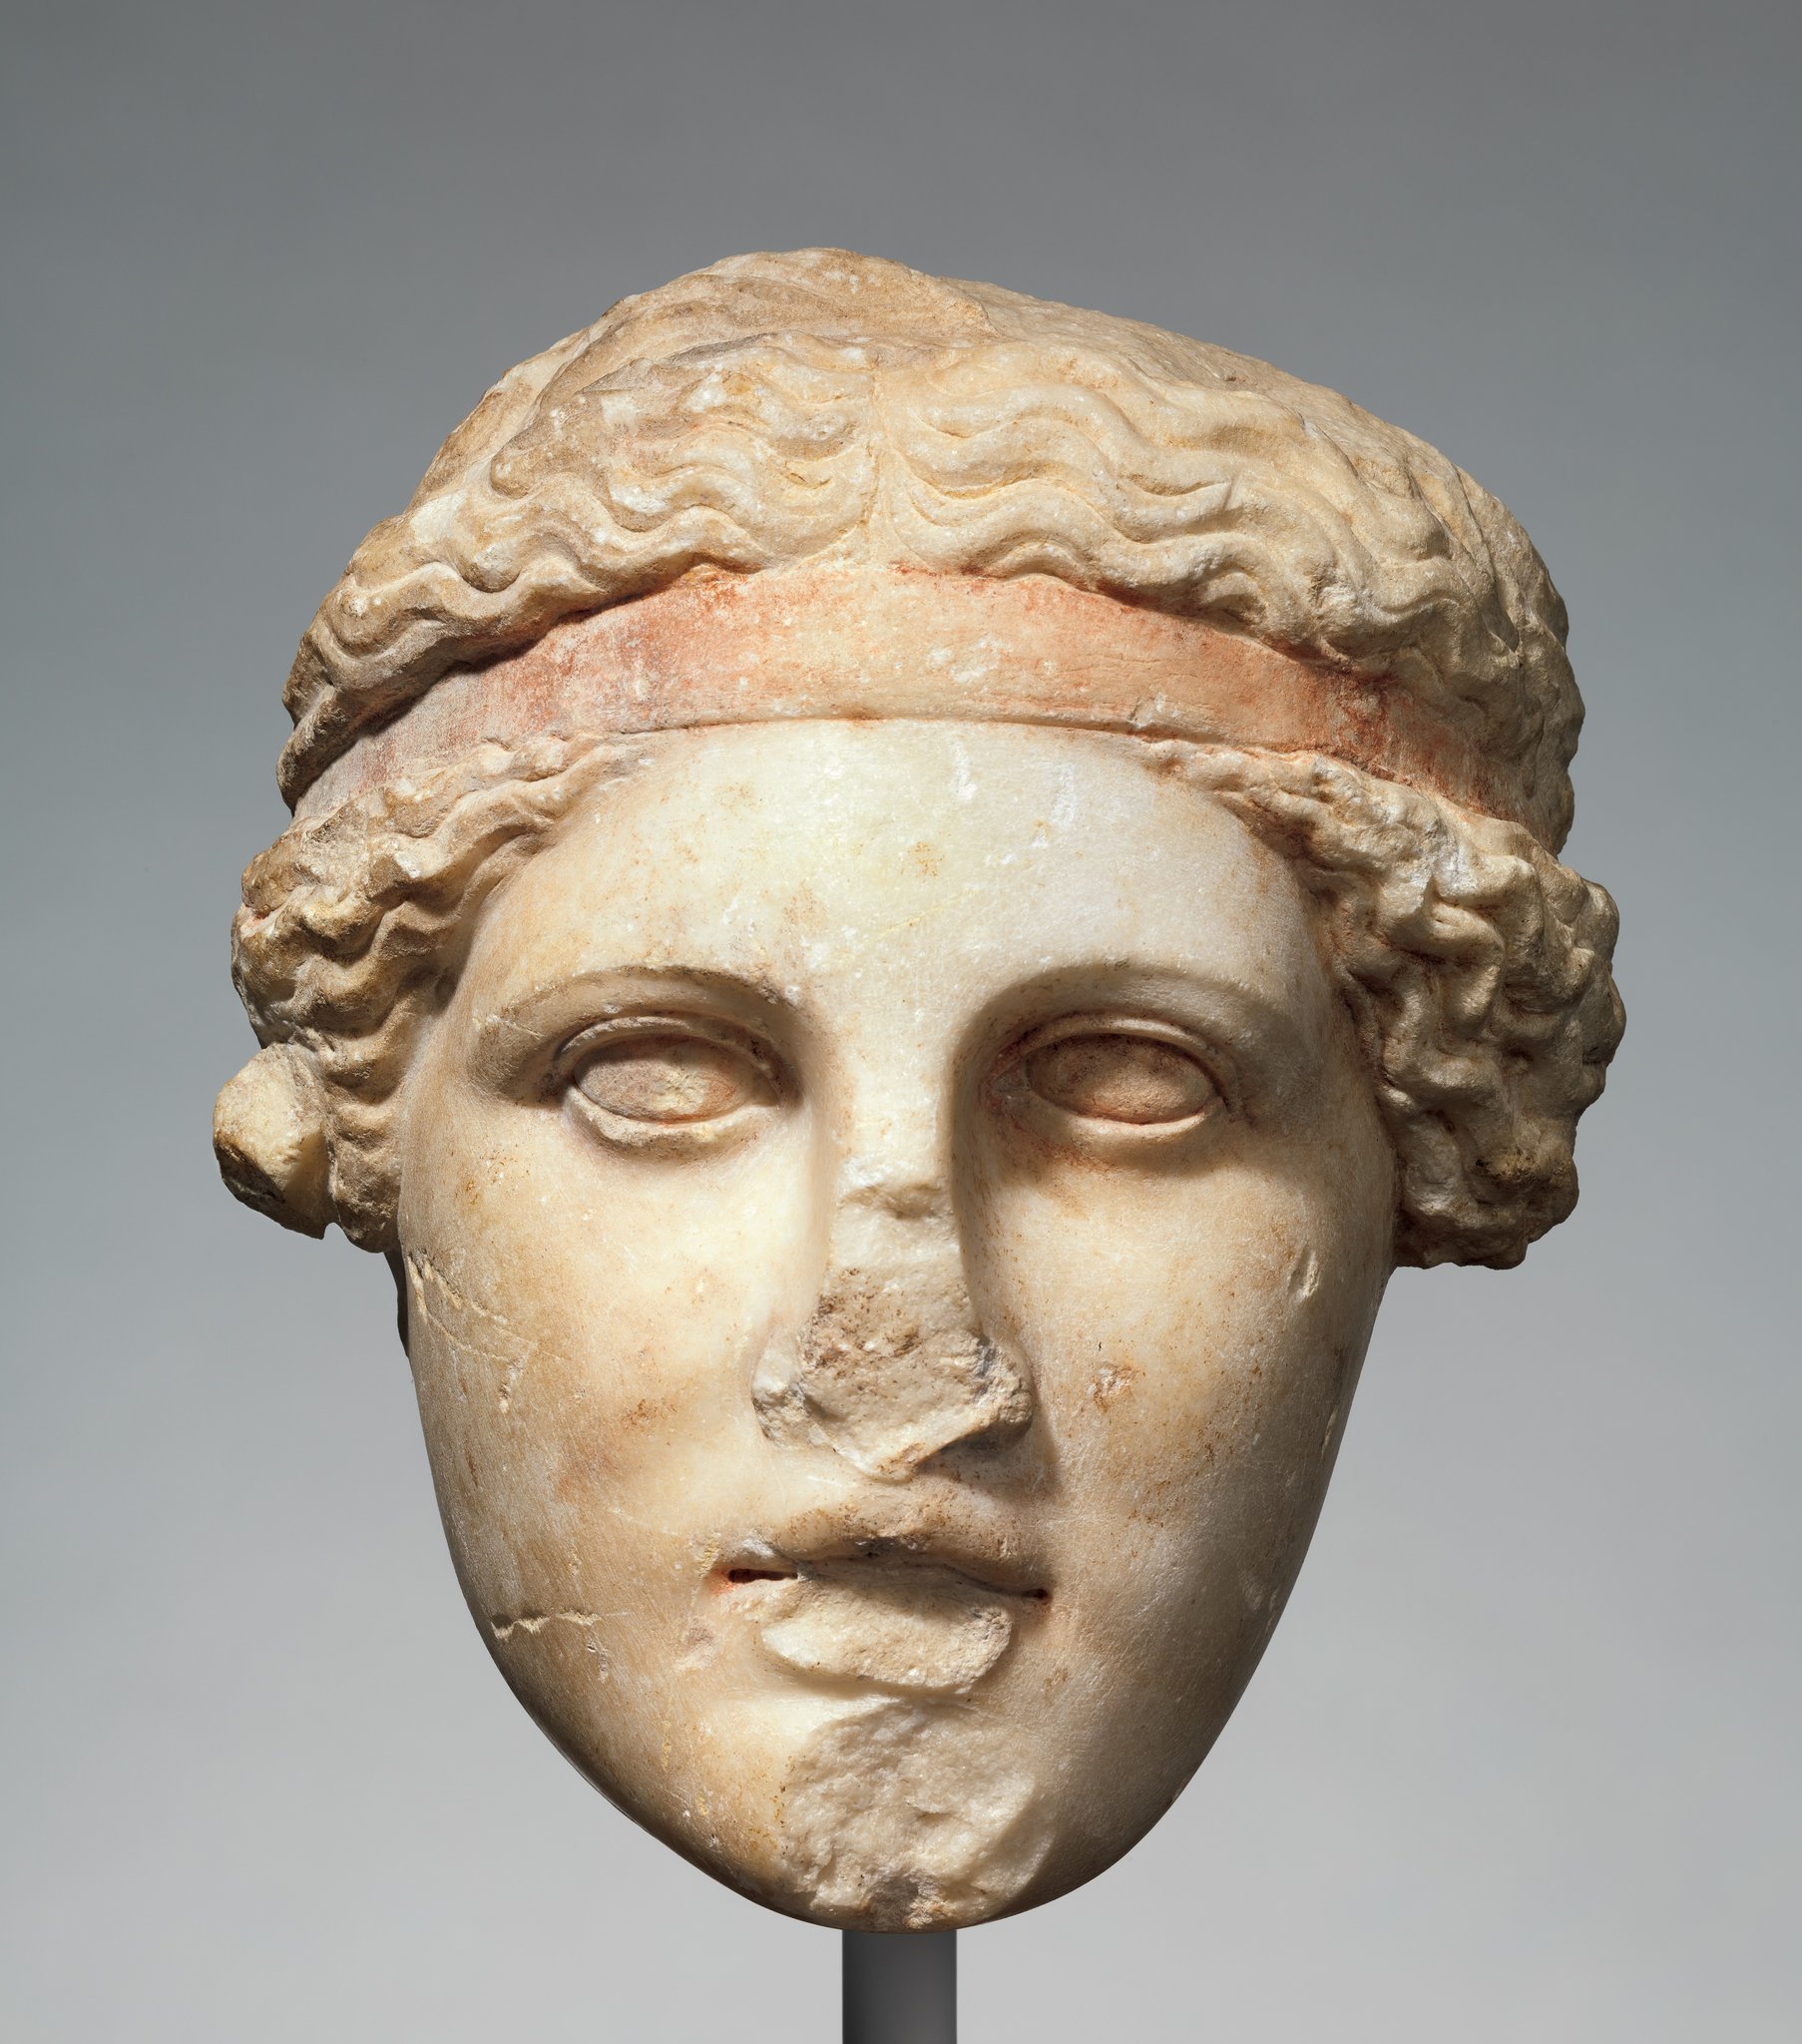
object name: head of a deity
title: Marble head of a deity wearing a Dionysiac fillet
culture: roman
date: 14-68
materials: marble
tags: heads